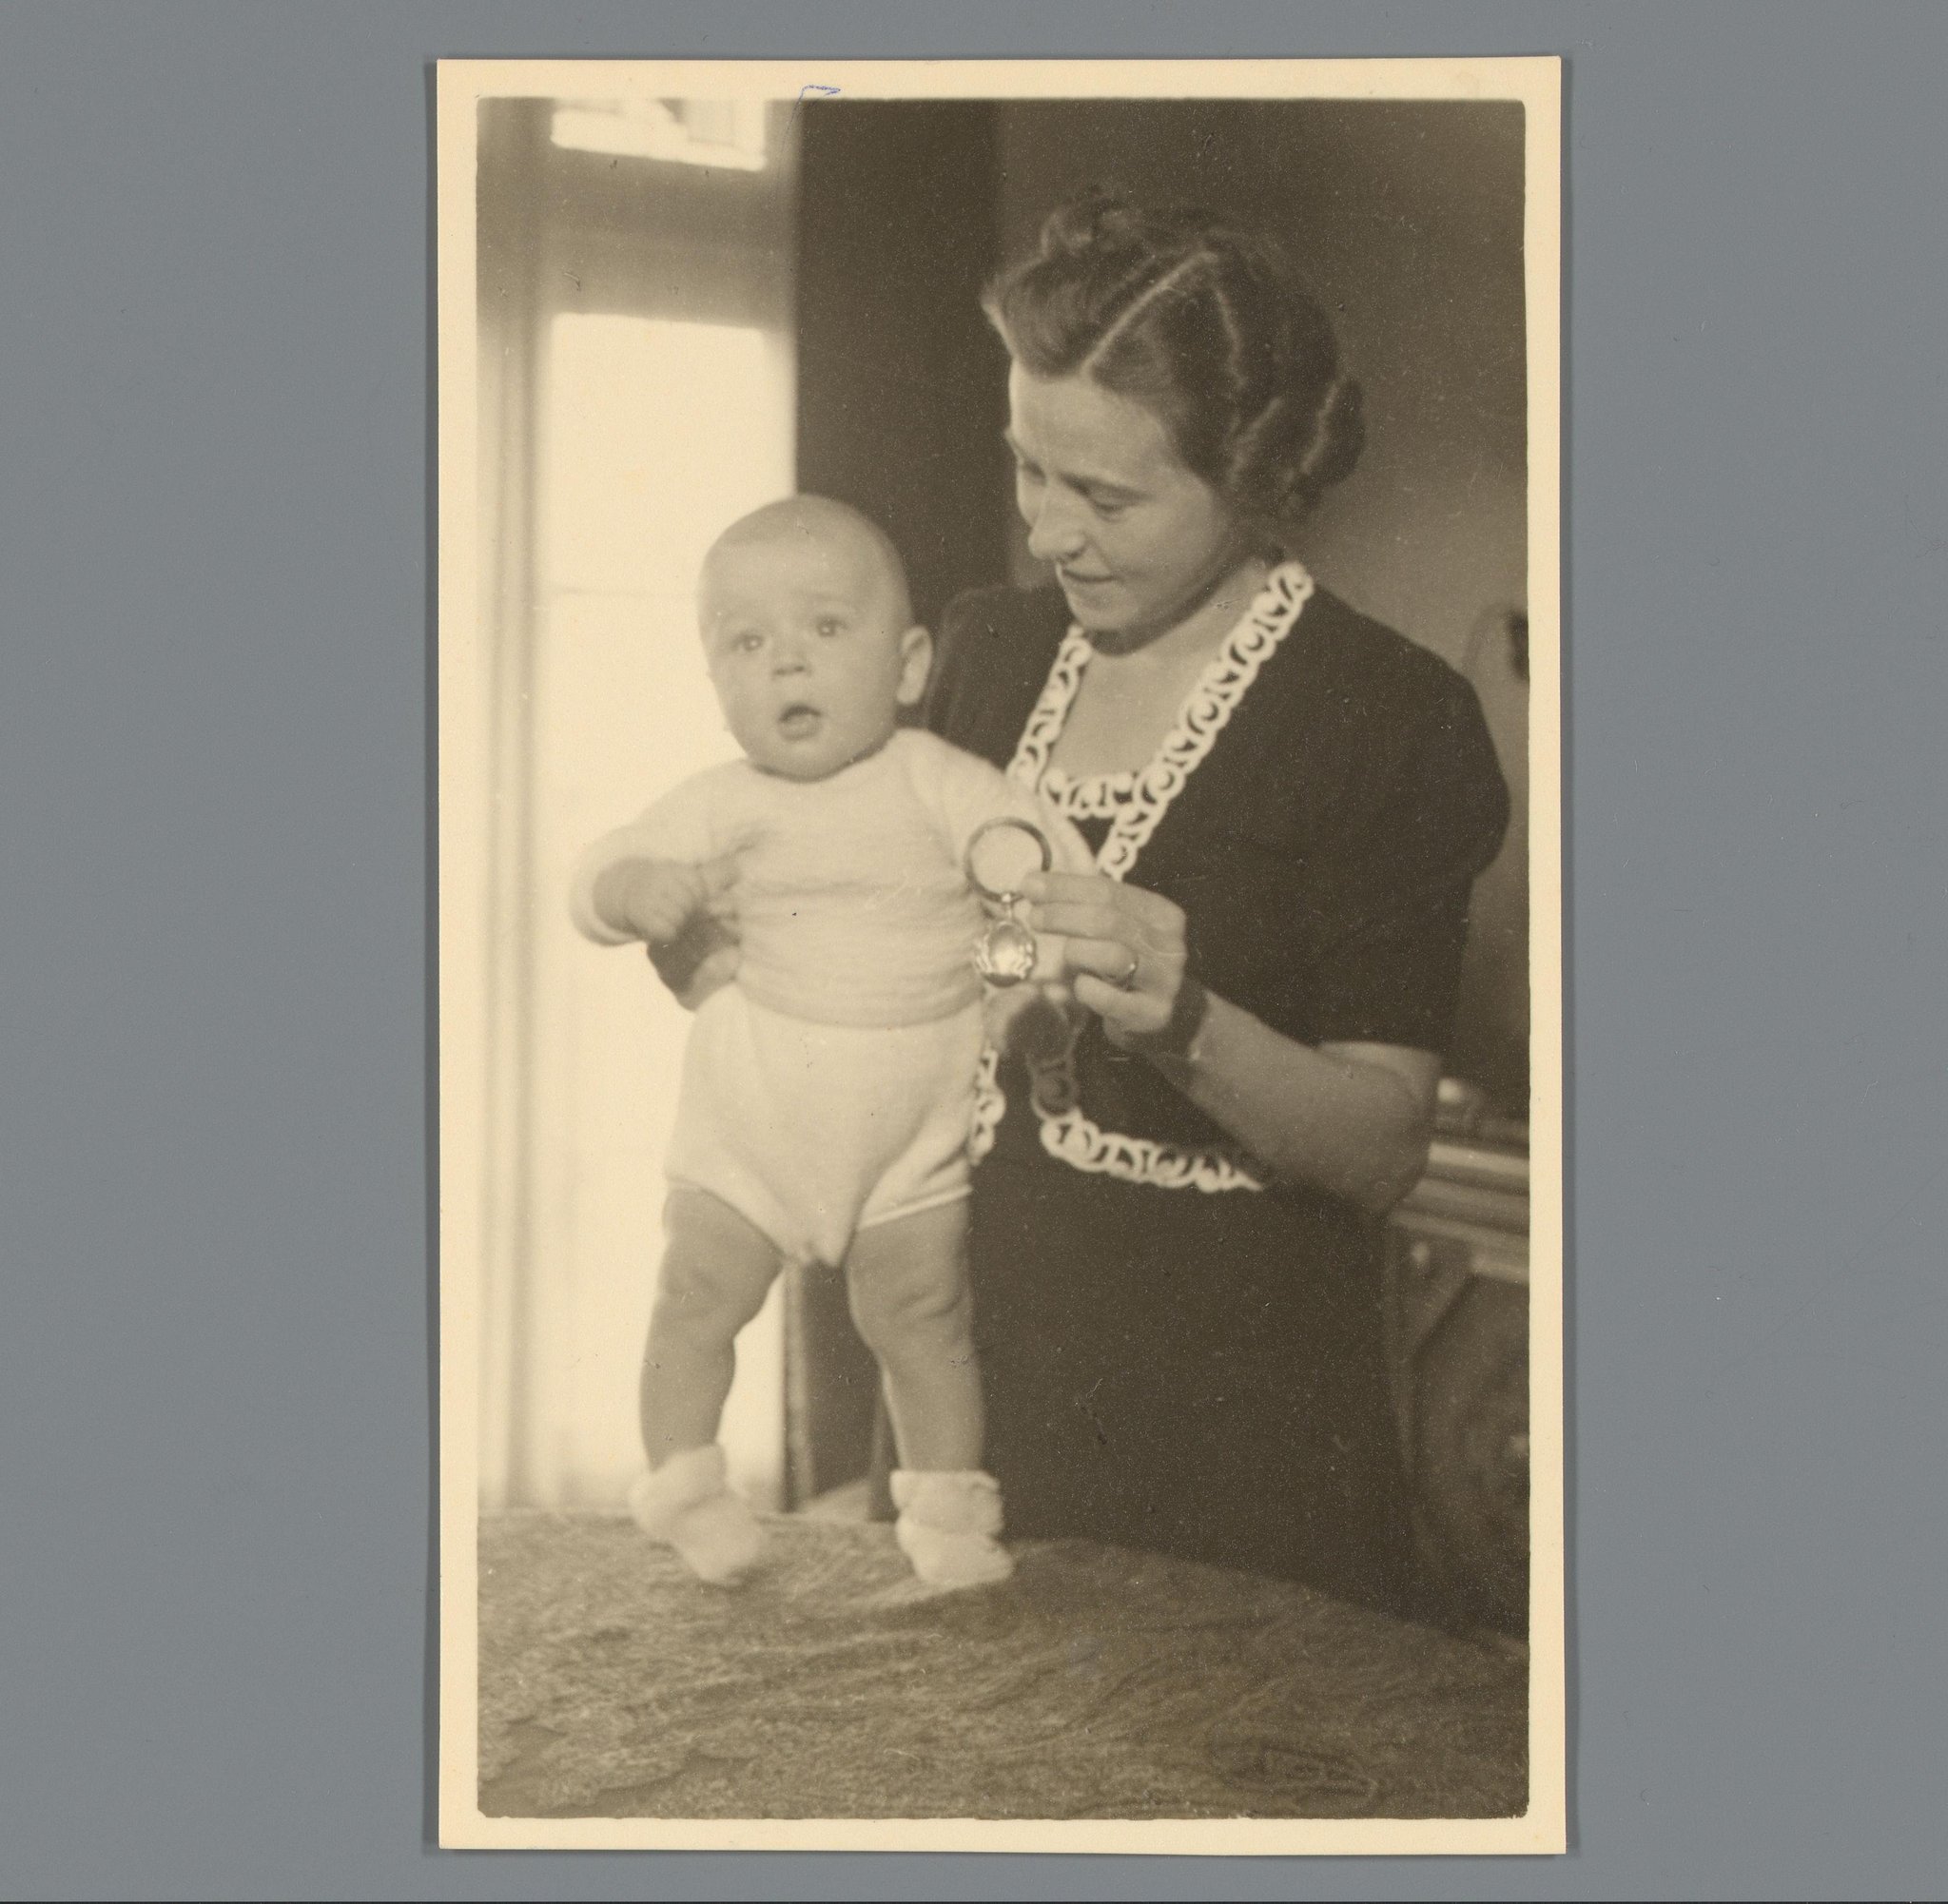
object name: photograph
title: Henk Swellengrebel als baby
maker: oosten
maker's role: fotograaf, fotohandel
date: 1912-1942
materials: cardboard, photographic support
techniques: gelatin silver print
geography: delft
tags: delft, historical persons, mother and baby or young child, infant, baby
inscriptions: inscription: ‘dec. 1942 Moder met Henk. Vader in gevangenkamp Duitsland!’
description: Henk Swellengrebel als baby van zeven maanden met zijn moeder Anne Sofie Knagenhjelm Gregory. Foto uitgevoerd als prentbriefkaart.